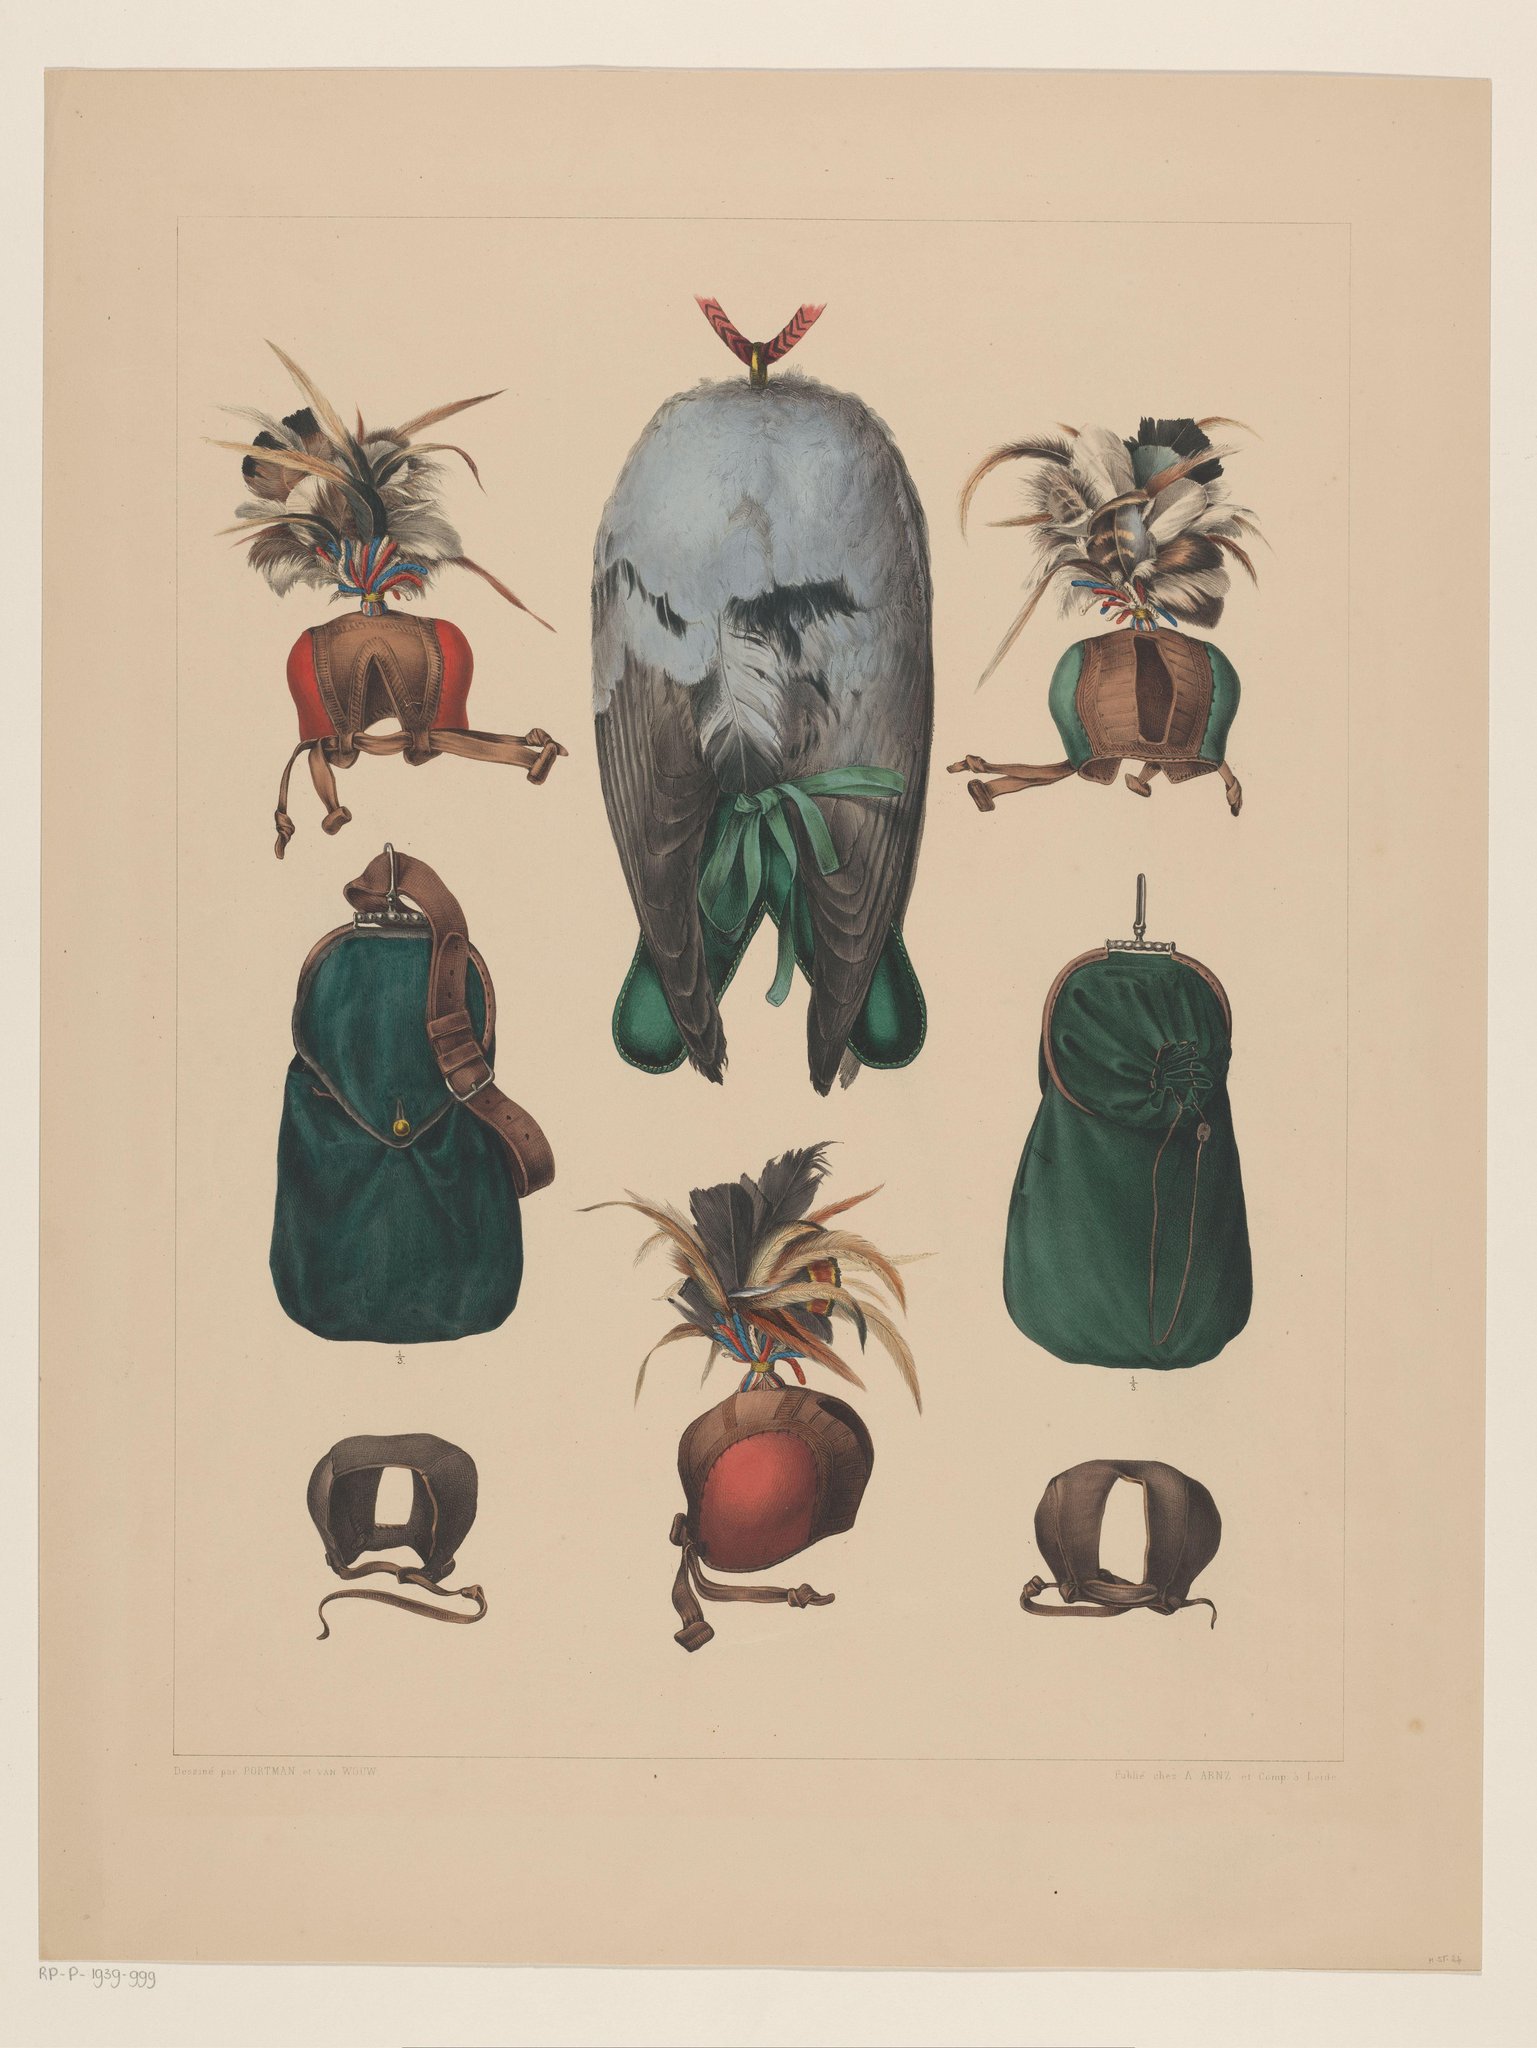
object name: book illustration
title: Attributen van valkerij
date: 1844-1853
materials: paper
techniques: lithograph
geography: leiden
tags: predatory birds: falcon, sports, games ~ animals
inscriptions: collector's mark: Lugt 2228, collector's mark: Lugt 2760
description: Prent uit: Schlegel, Hermann; Verster van Wulverhorst, Abraham H. Traité de fauconnerie. Leiden en Düsseldorf: Arnz & Co., August, 1844-1853.